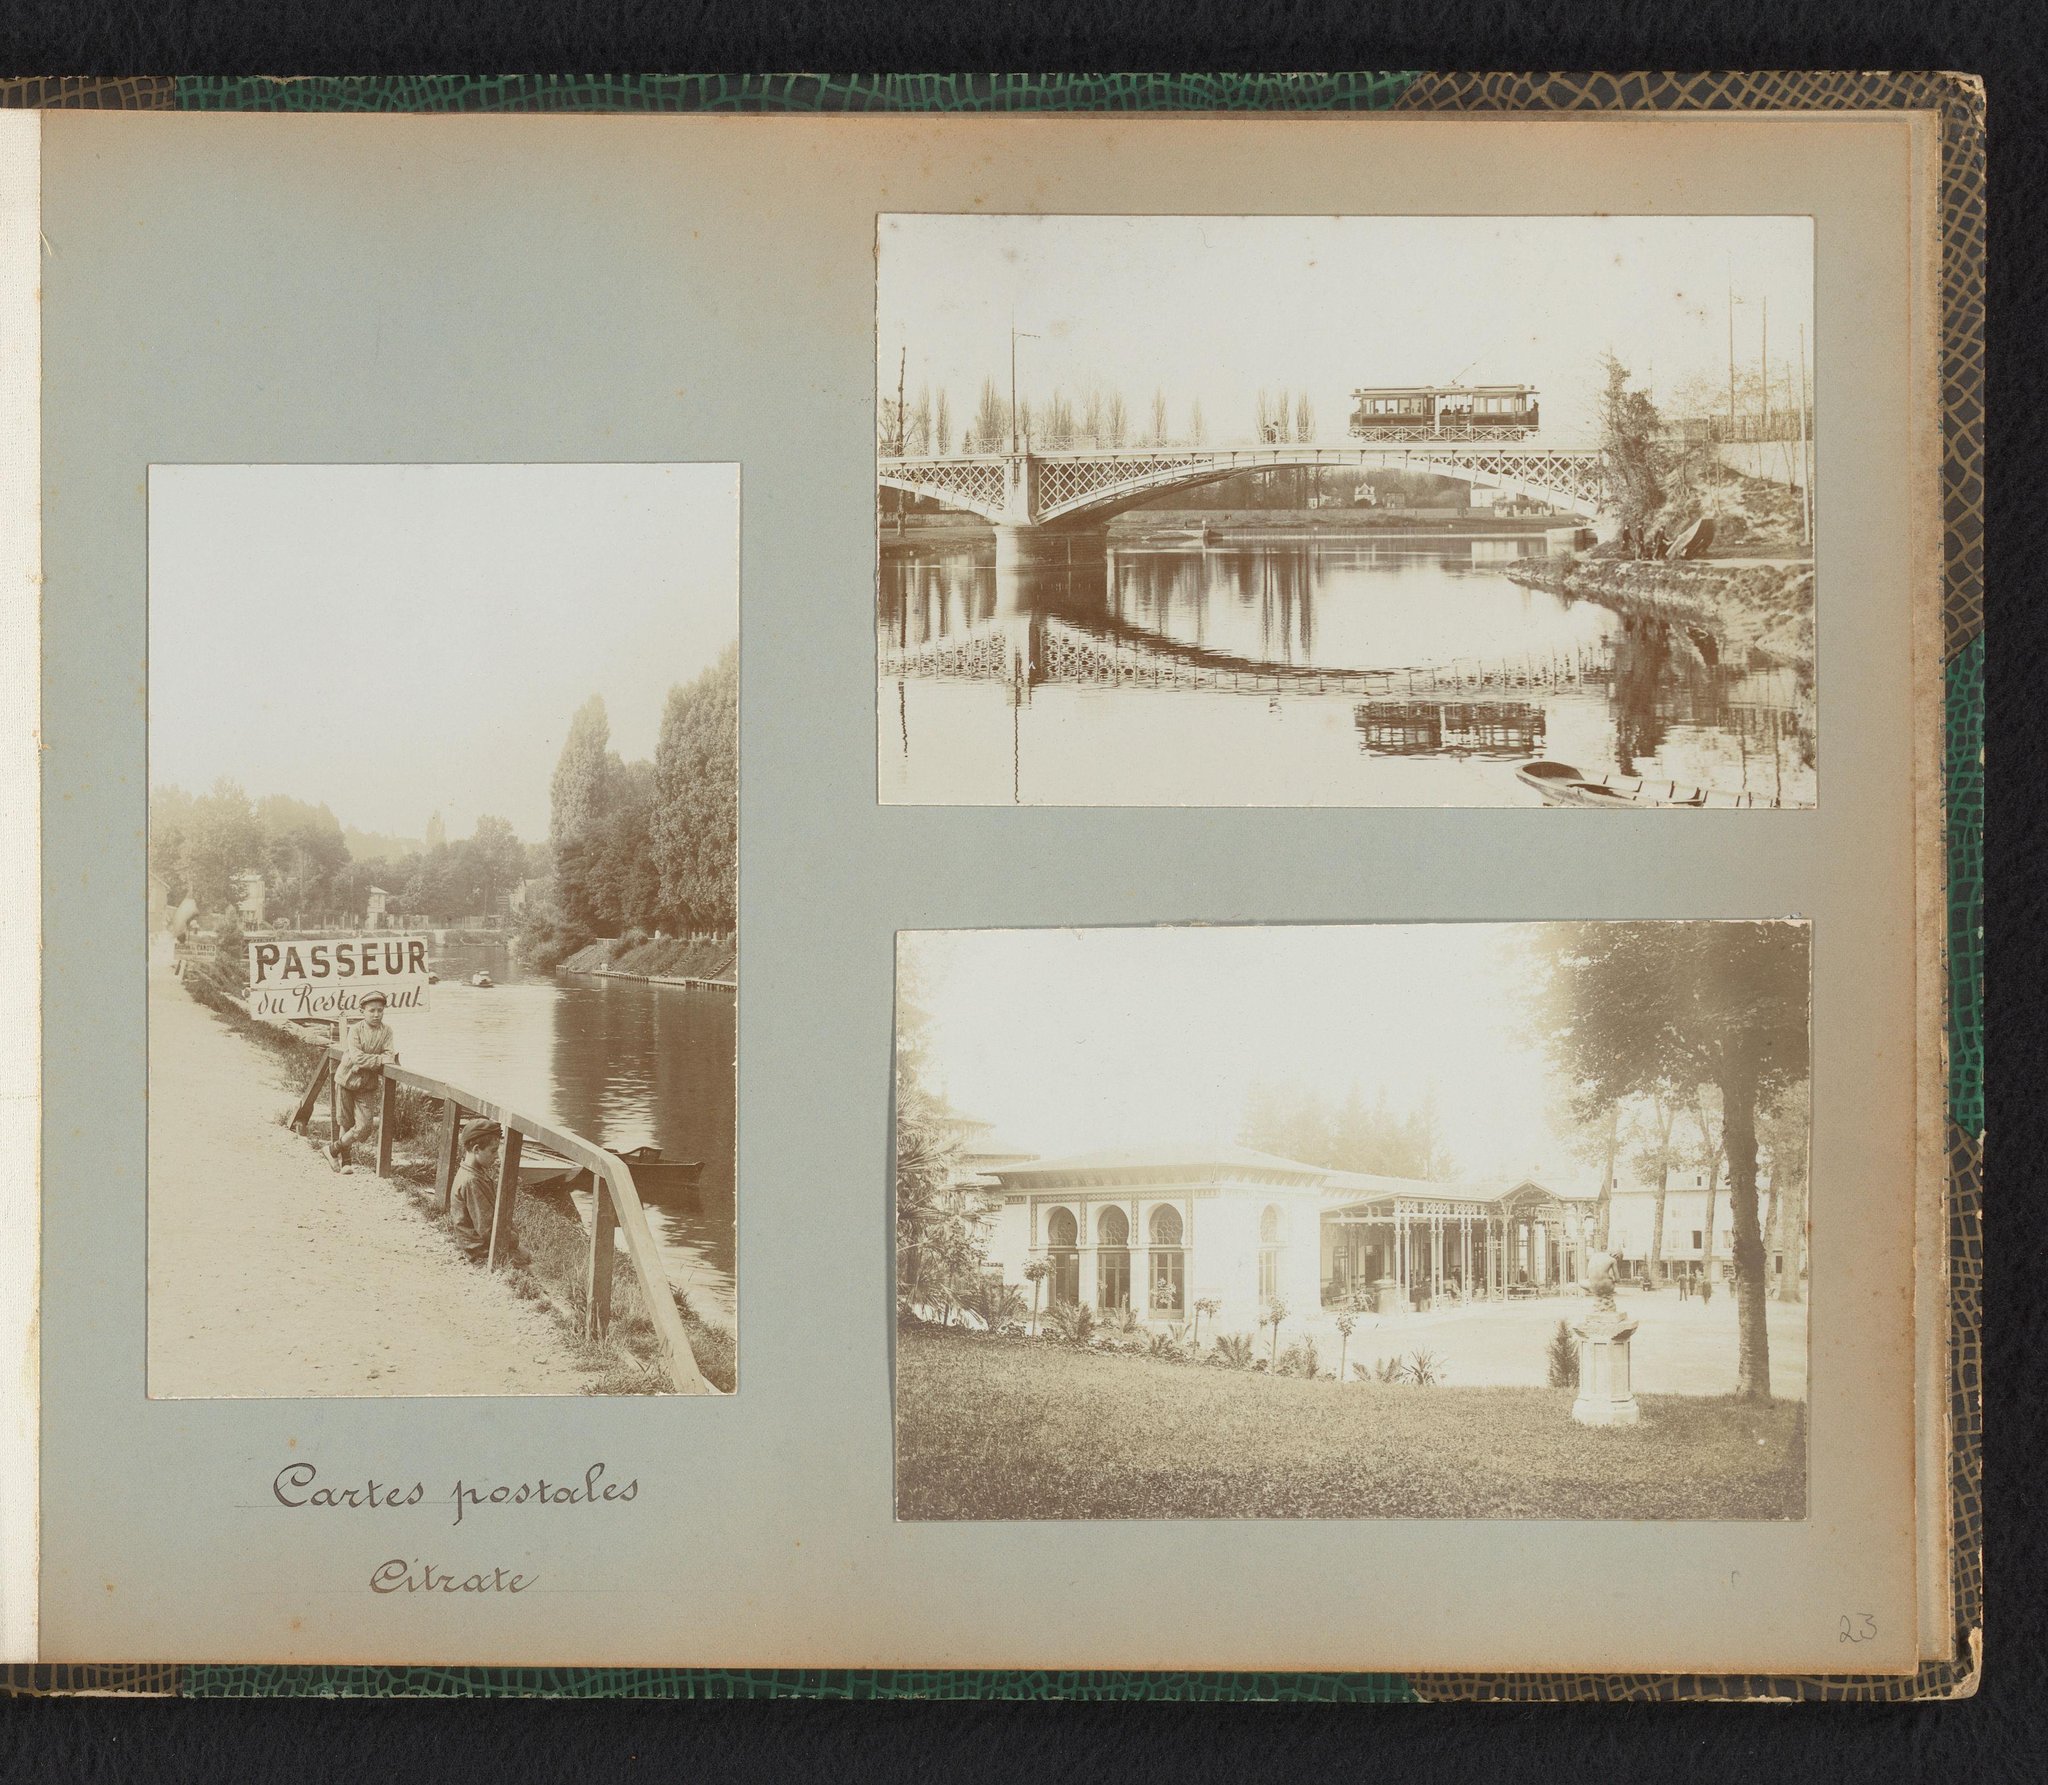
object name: photograph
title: Twee jongens staan langs een rivier met reclamebord, gezicht op een brug met daarop een tram en een gezicht op een gebouw met terras aan een plein en een standbeeld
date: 1890-1910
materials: paper, cardboard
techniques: gelatin silver print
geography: paris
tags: tram, river, boy (child between toddler and youth), landscape with bridge, viaduct or aqueduct, monument, statue, pavement, terrace in front of inn or restaurant, historical persons not known by name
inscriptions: inscription: ‘Cartes postales/ Citrate’